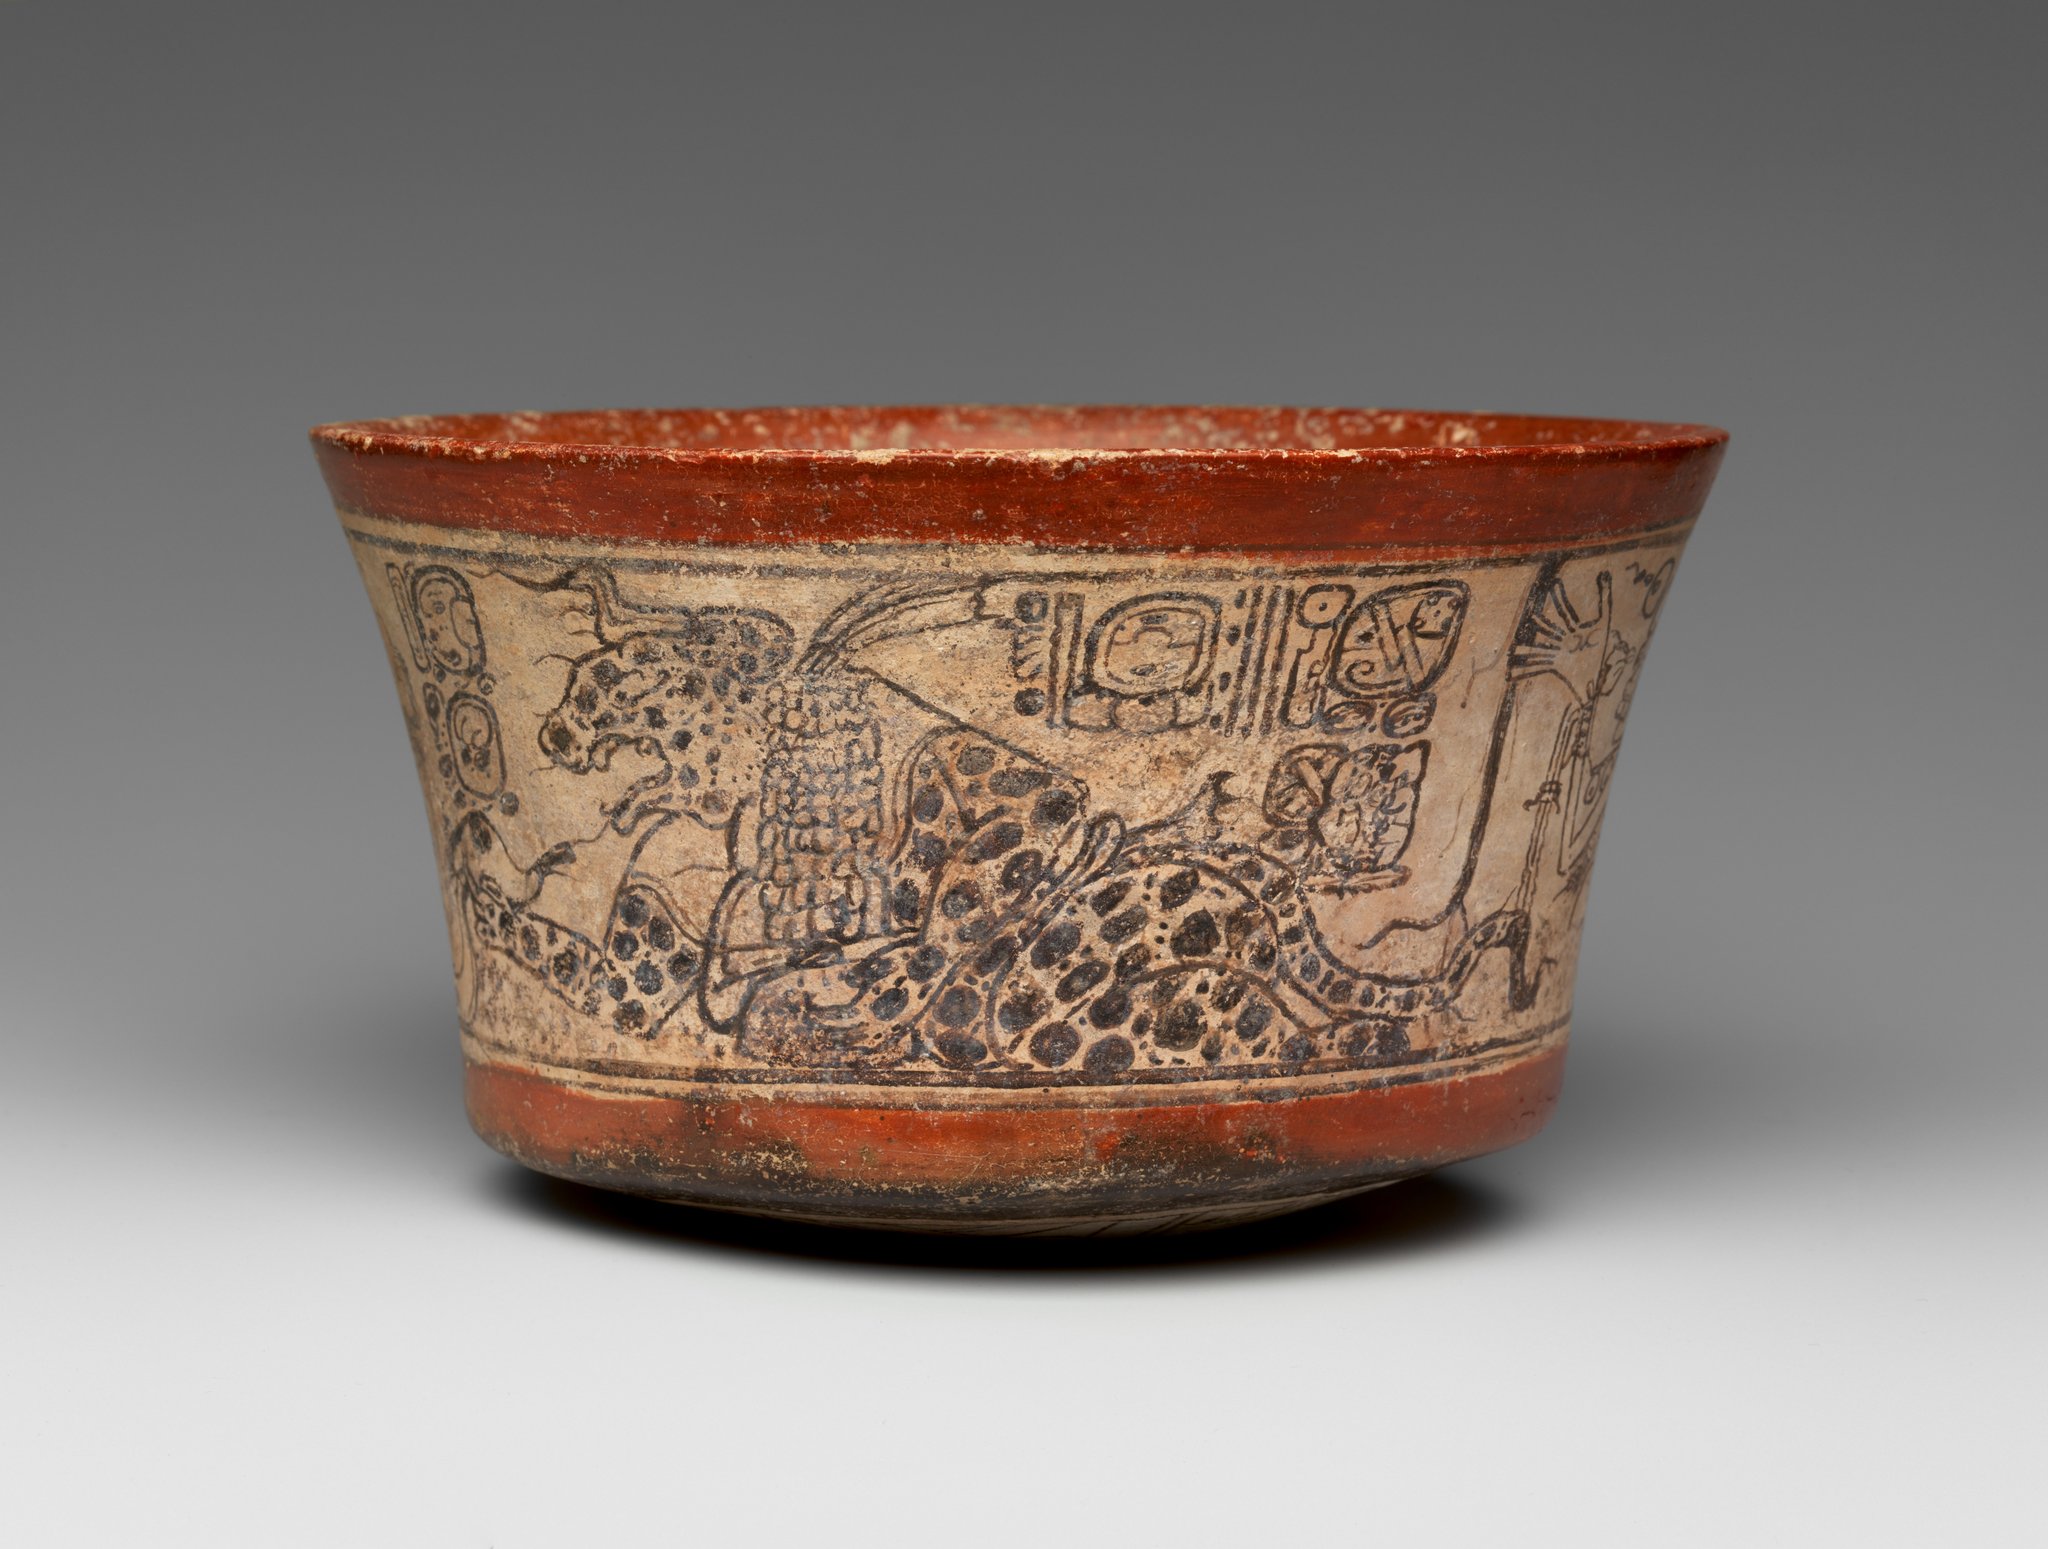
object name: bowl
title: Bowl, Mythological Scene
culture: maya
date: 701-800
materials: ceramic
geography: guatemala or mexico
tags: animals,mythical creatures